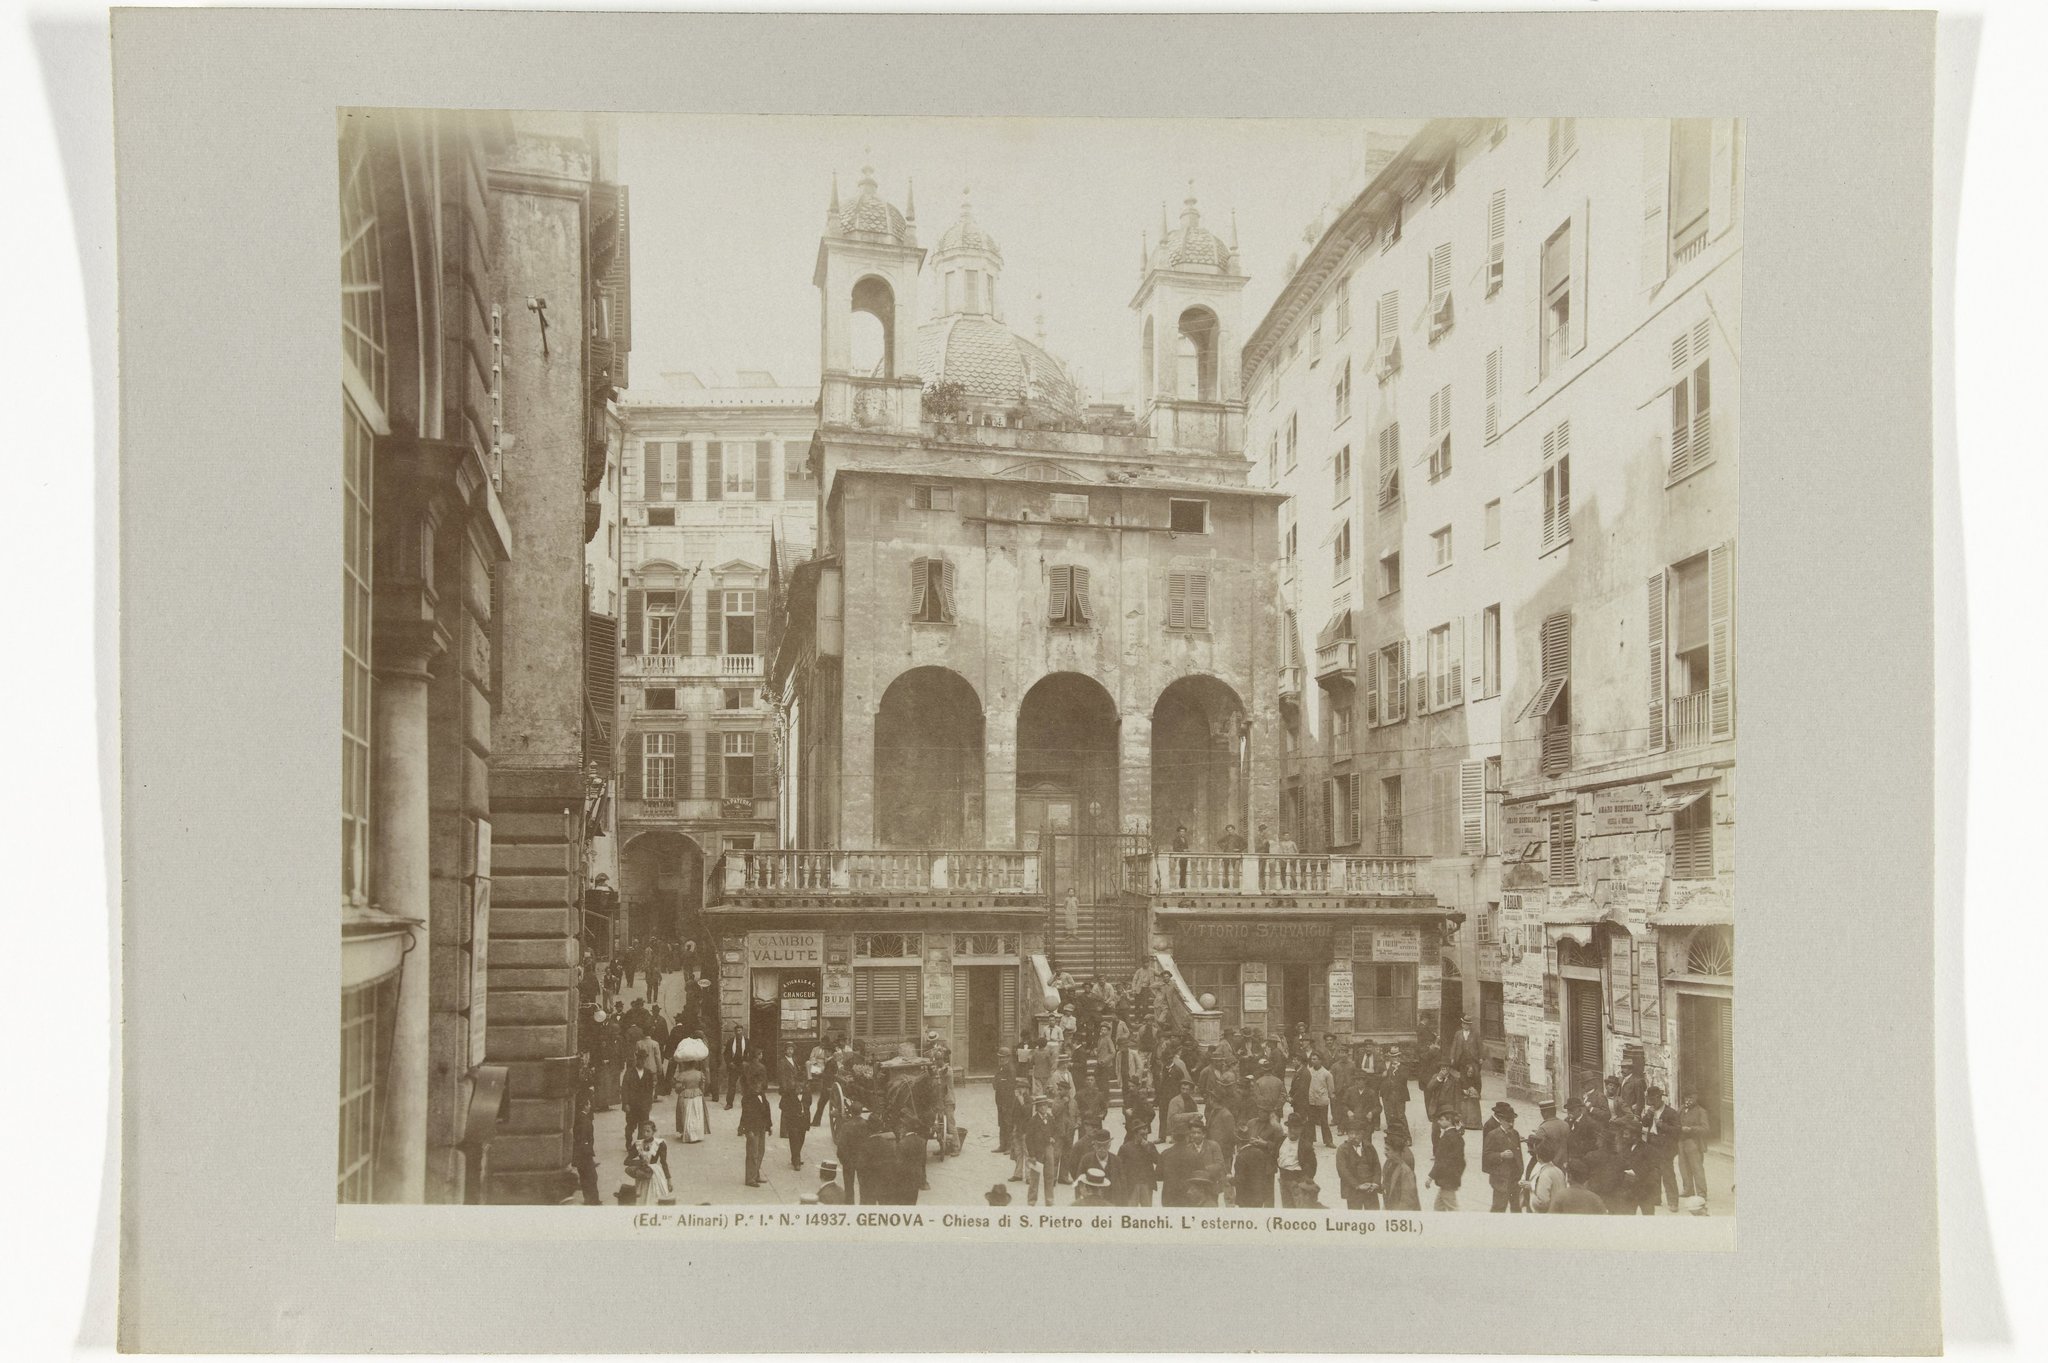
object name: photograph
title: P.e 1.a N.o 14937. GENOVA - Chiesa di S. Pietro dei Banchi. L'esterno. (Rocco Lurago 1581.)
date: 1898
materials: cardboard, paper, photographic support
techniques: albumen print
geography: florence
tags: church (exterior)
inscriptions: number: ‘97.’